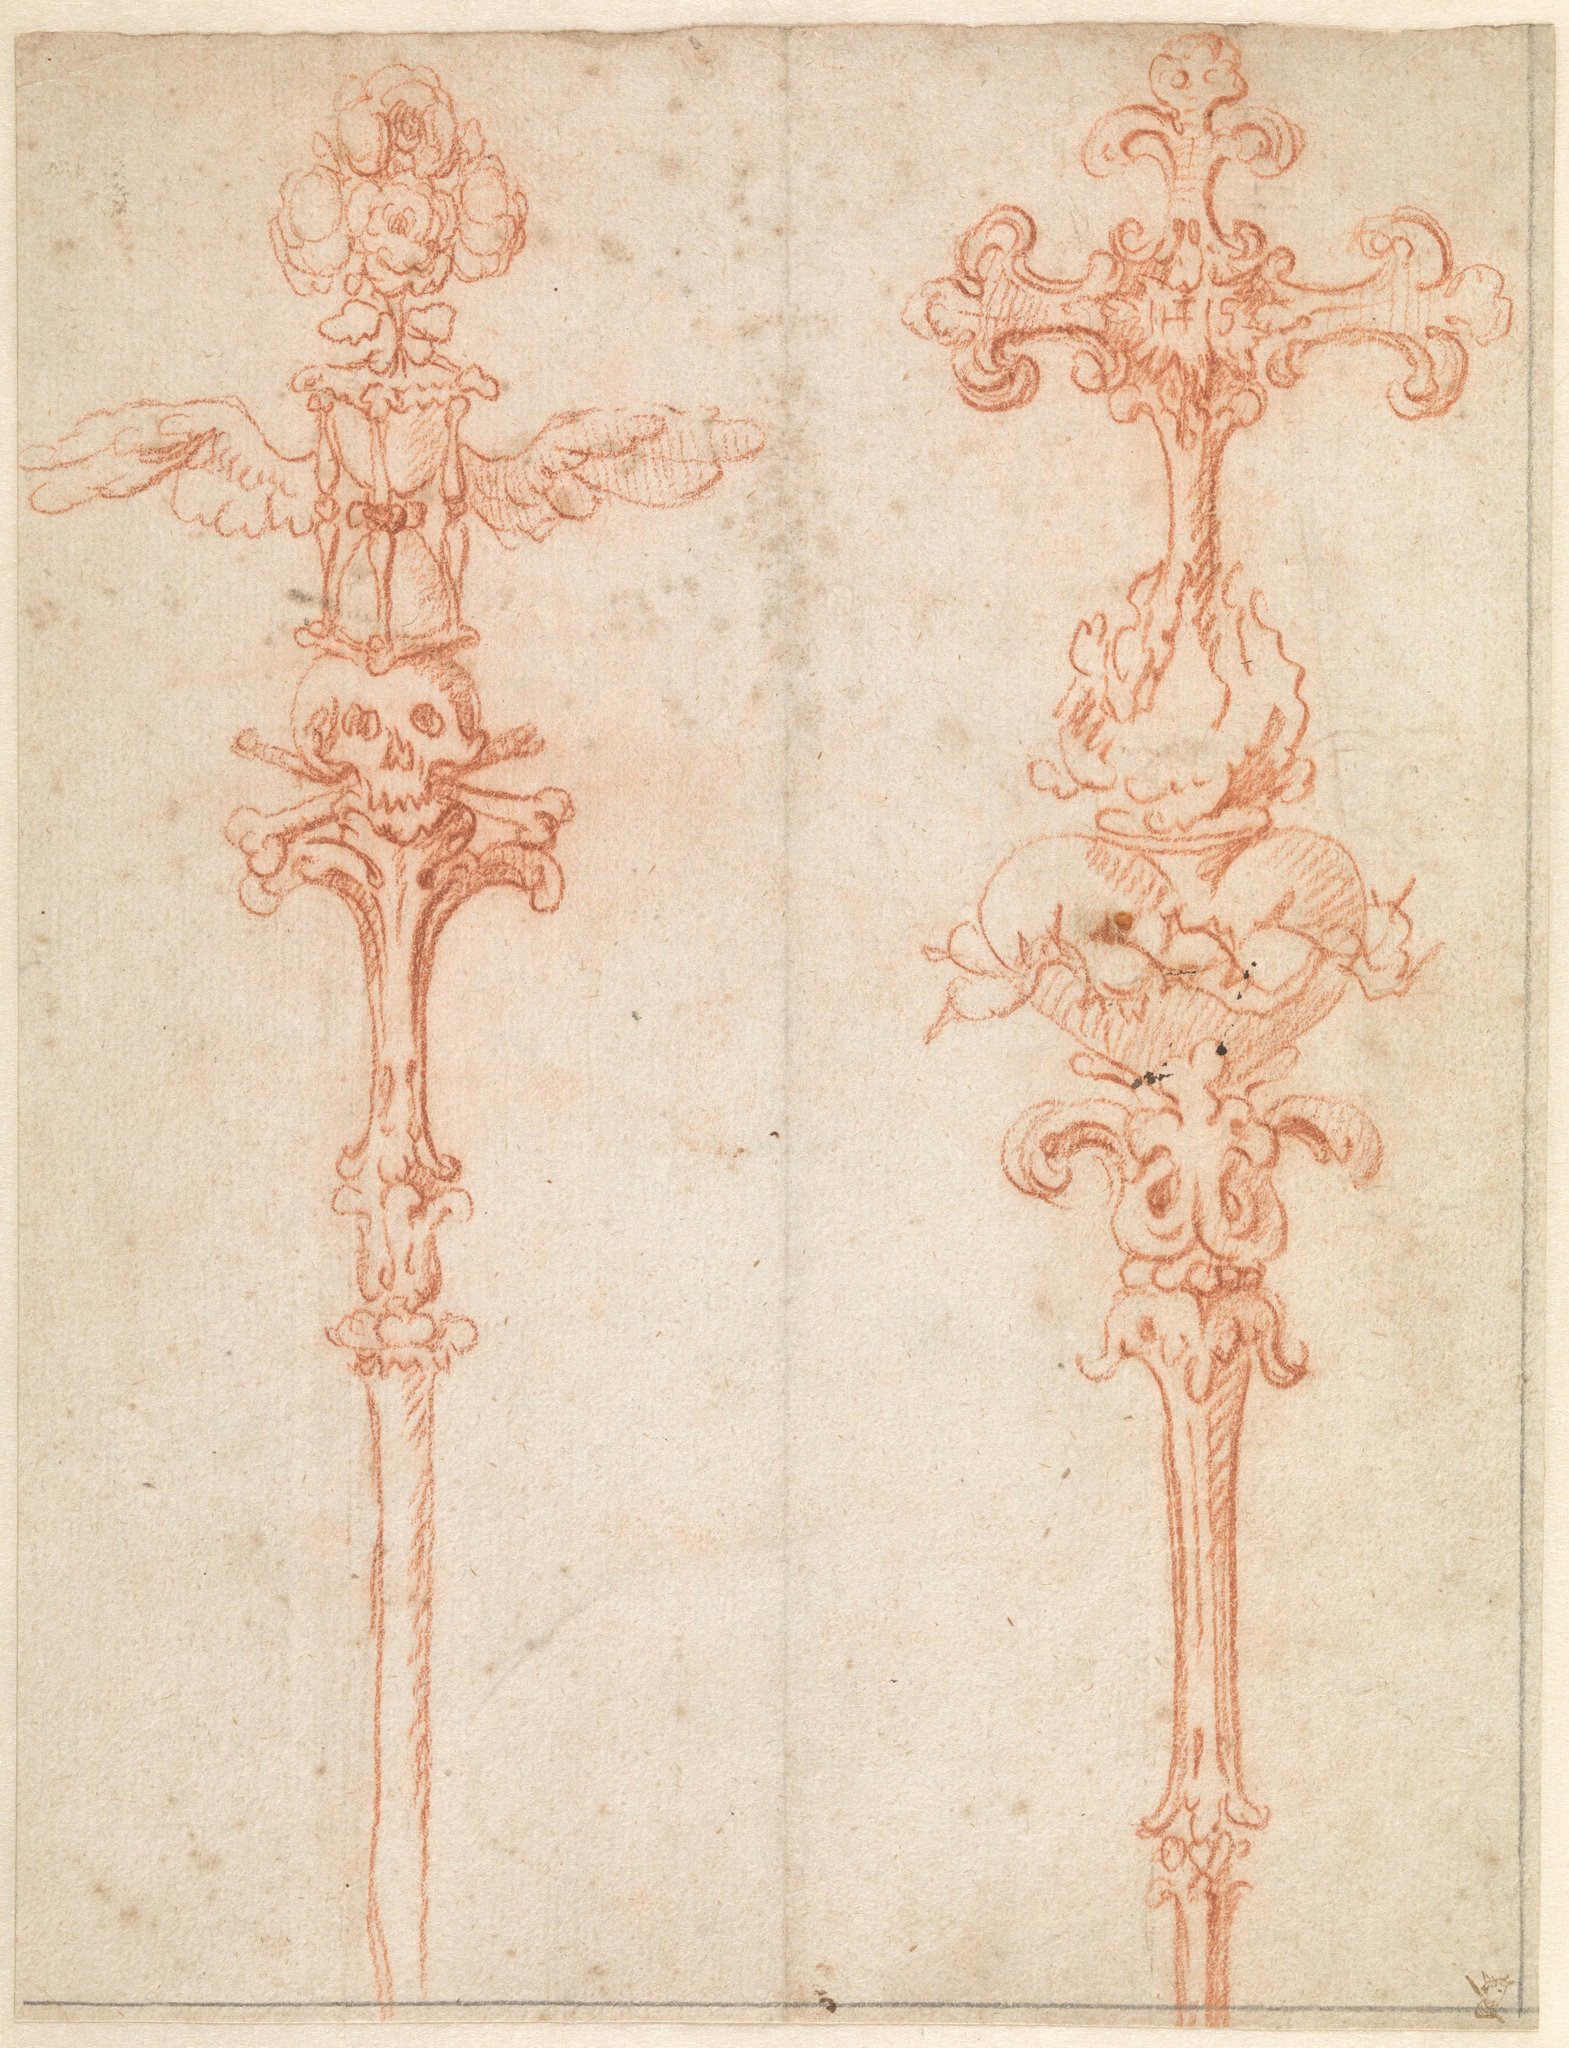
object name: drawing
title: Ontwerp voor twee begrafeniskruizen of -staven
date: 1680-1700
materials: chalk, paper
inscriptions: watermark: ‘naar links lopende leeuw’, collector's mark: Lugt 3893, collector's mark: ‘Lodewijk Houthakker (L. 3893)’